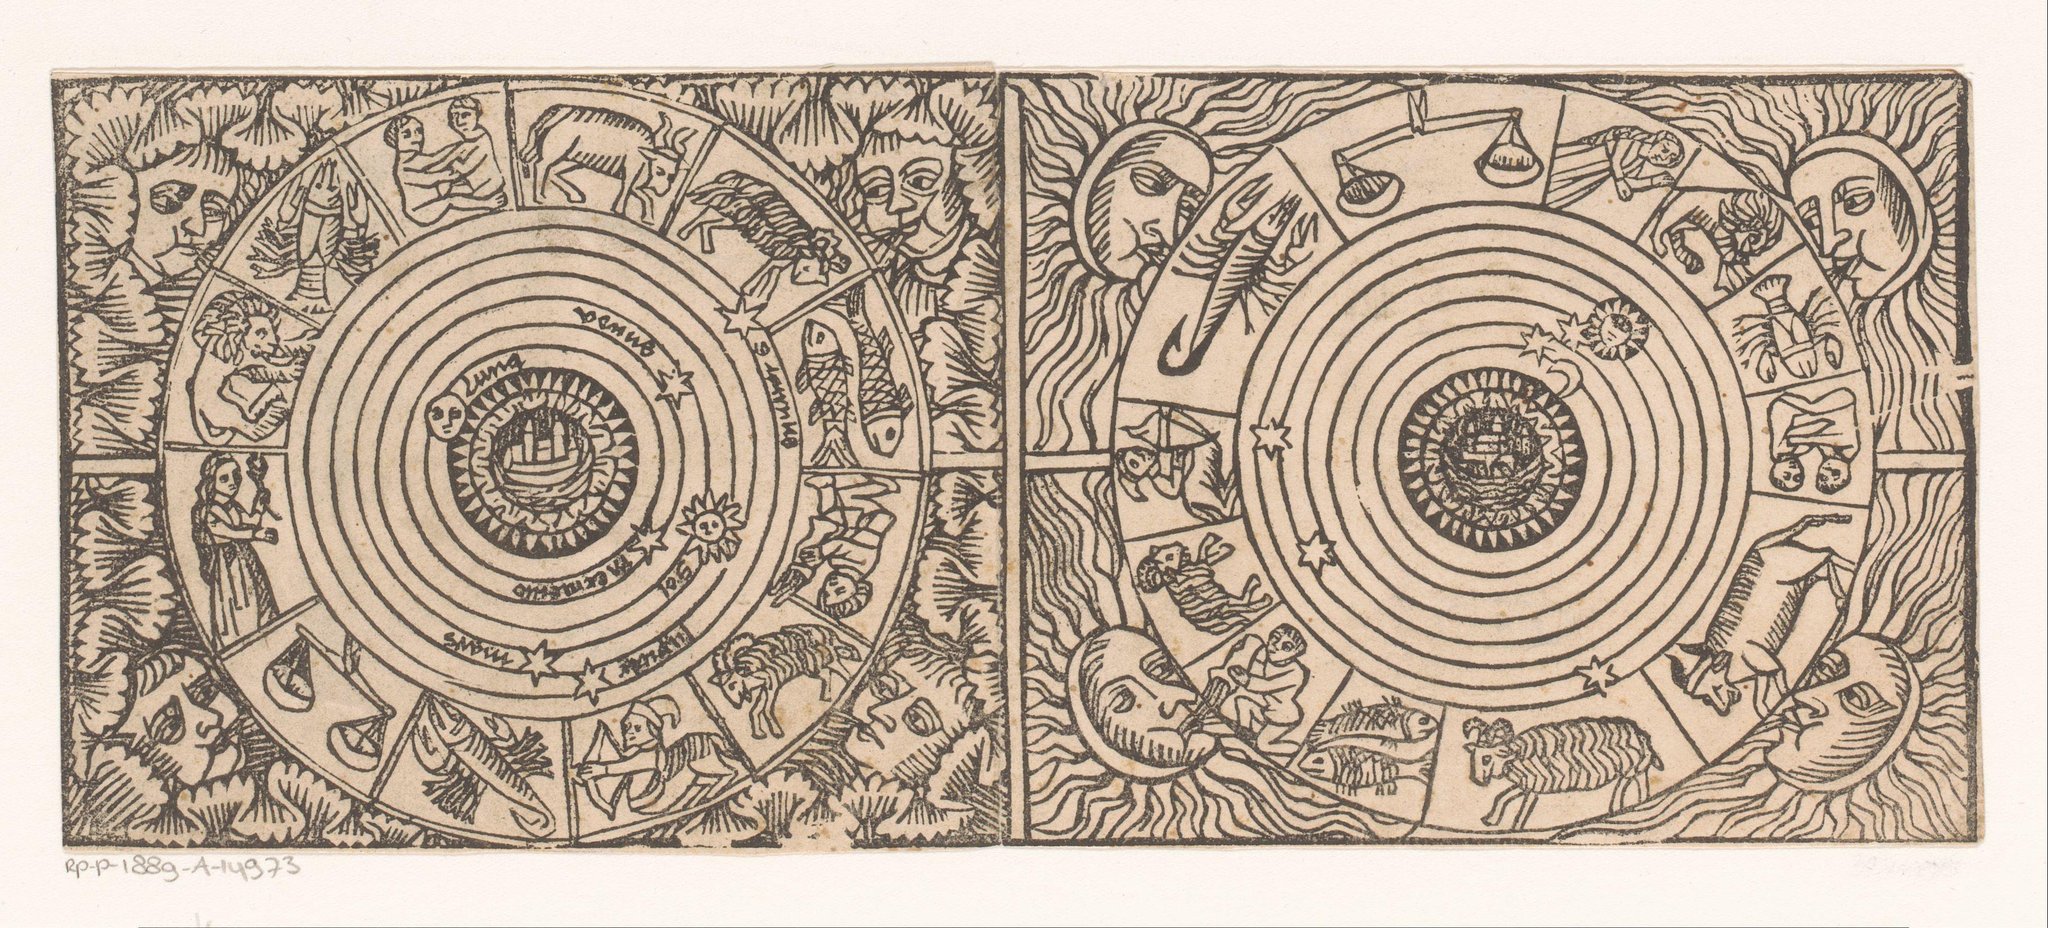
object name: print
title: Dierenriem met de twaalf hemeltekens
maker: Anonymous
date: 1600-1699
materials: paper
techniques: woodcut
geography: netherlands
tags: cheeks rounded, zodiac; the twelve zodiacal signs together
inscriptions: collector's mark: Lugt 2228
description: Twee cirkels met de tekens van de dierenriem, de zon, de maan en sterren. In de hoeken blazende figuren met gebolde wangen.